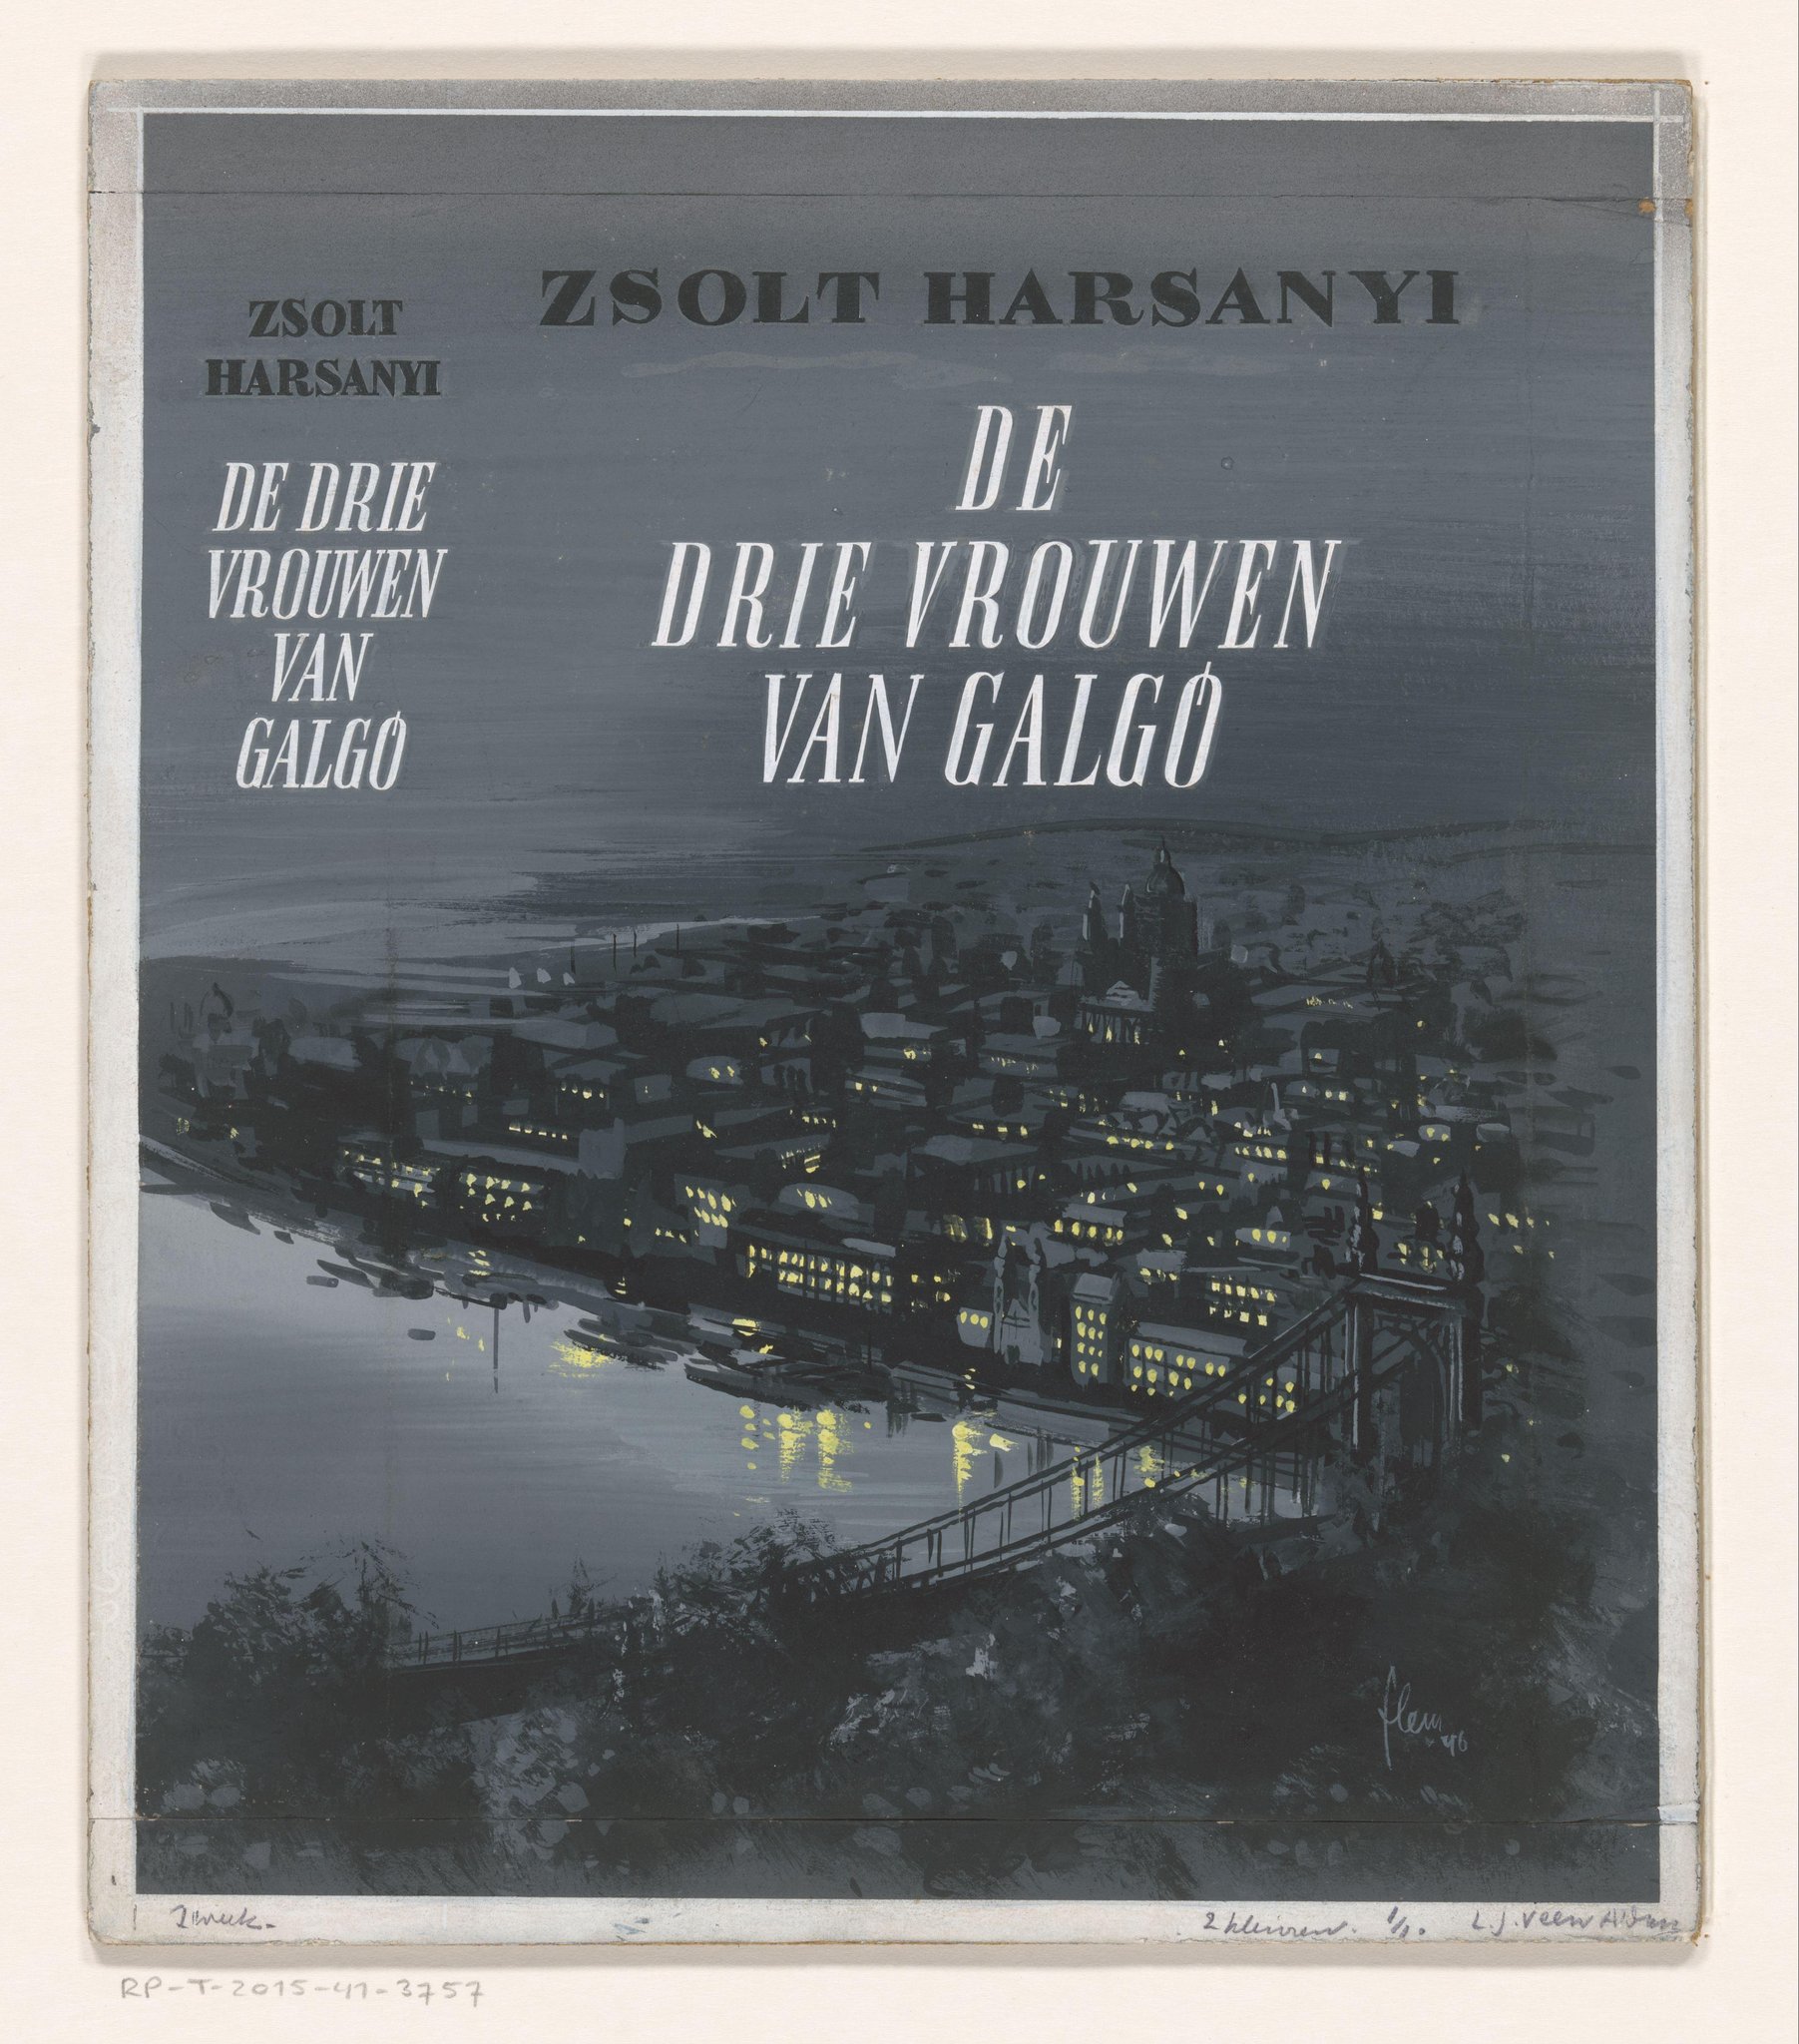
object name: drawing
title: Bandontwerp voor: Zsolt Harsányi, De drie vrouwen van Galgó (Galgó három felesége), 1948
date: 1946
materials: cardboard, paint, pencil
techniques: brush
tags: bridge, prospect of city, town panorama, silhouette of city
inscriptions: :, collector's mark: Lugt 2228a, signature and date: ‘flem 46’, workshop stamp: ‘STUDIO FLEM c.v./ ORANJELAAN 21/ 's-GRAVENHAGE/ TEEKENING/ No. 113’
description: Gezicht op een stad aan het water bij avond of nacht.